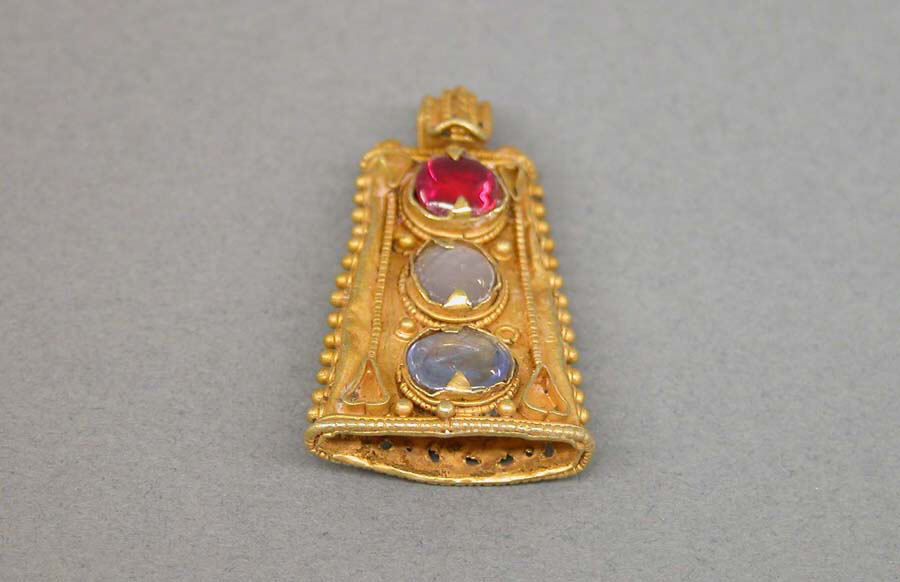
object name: pendant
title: Trapezoidal-Shaped Pendant with Granulate Border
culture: indonesian, javanese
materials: gold